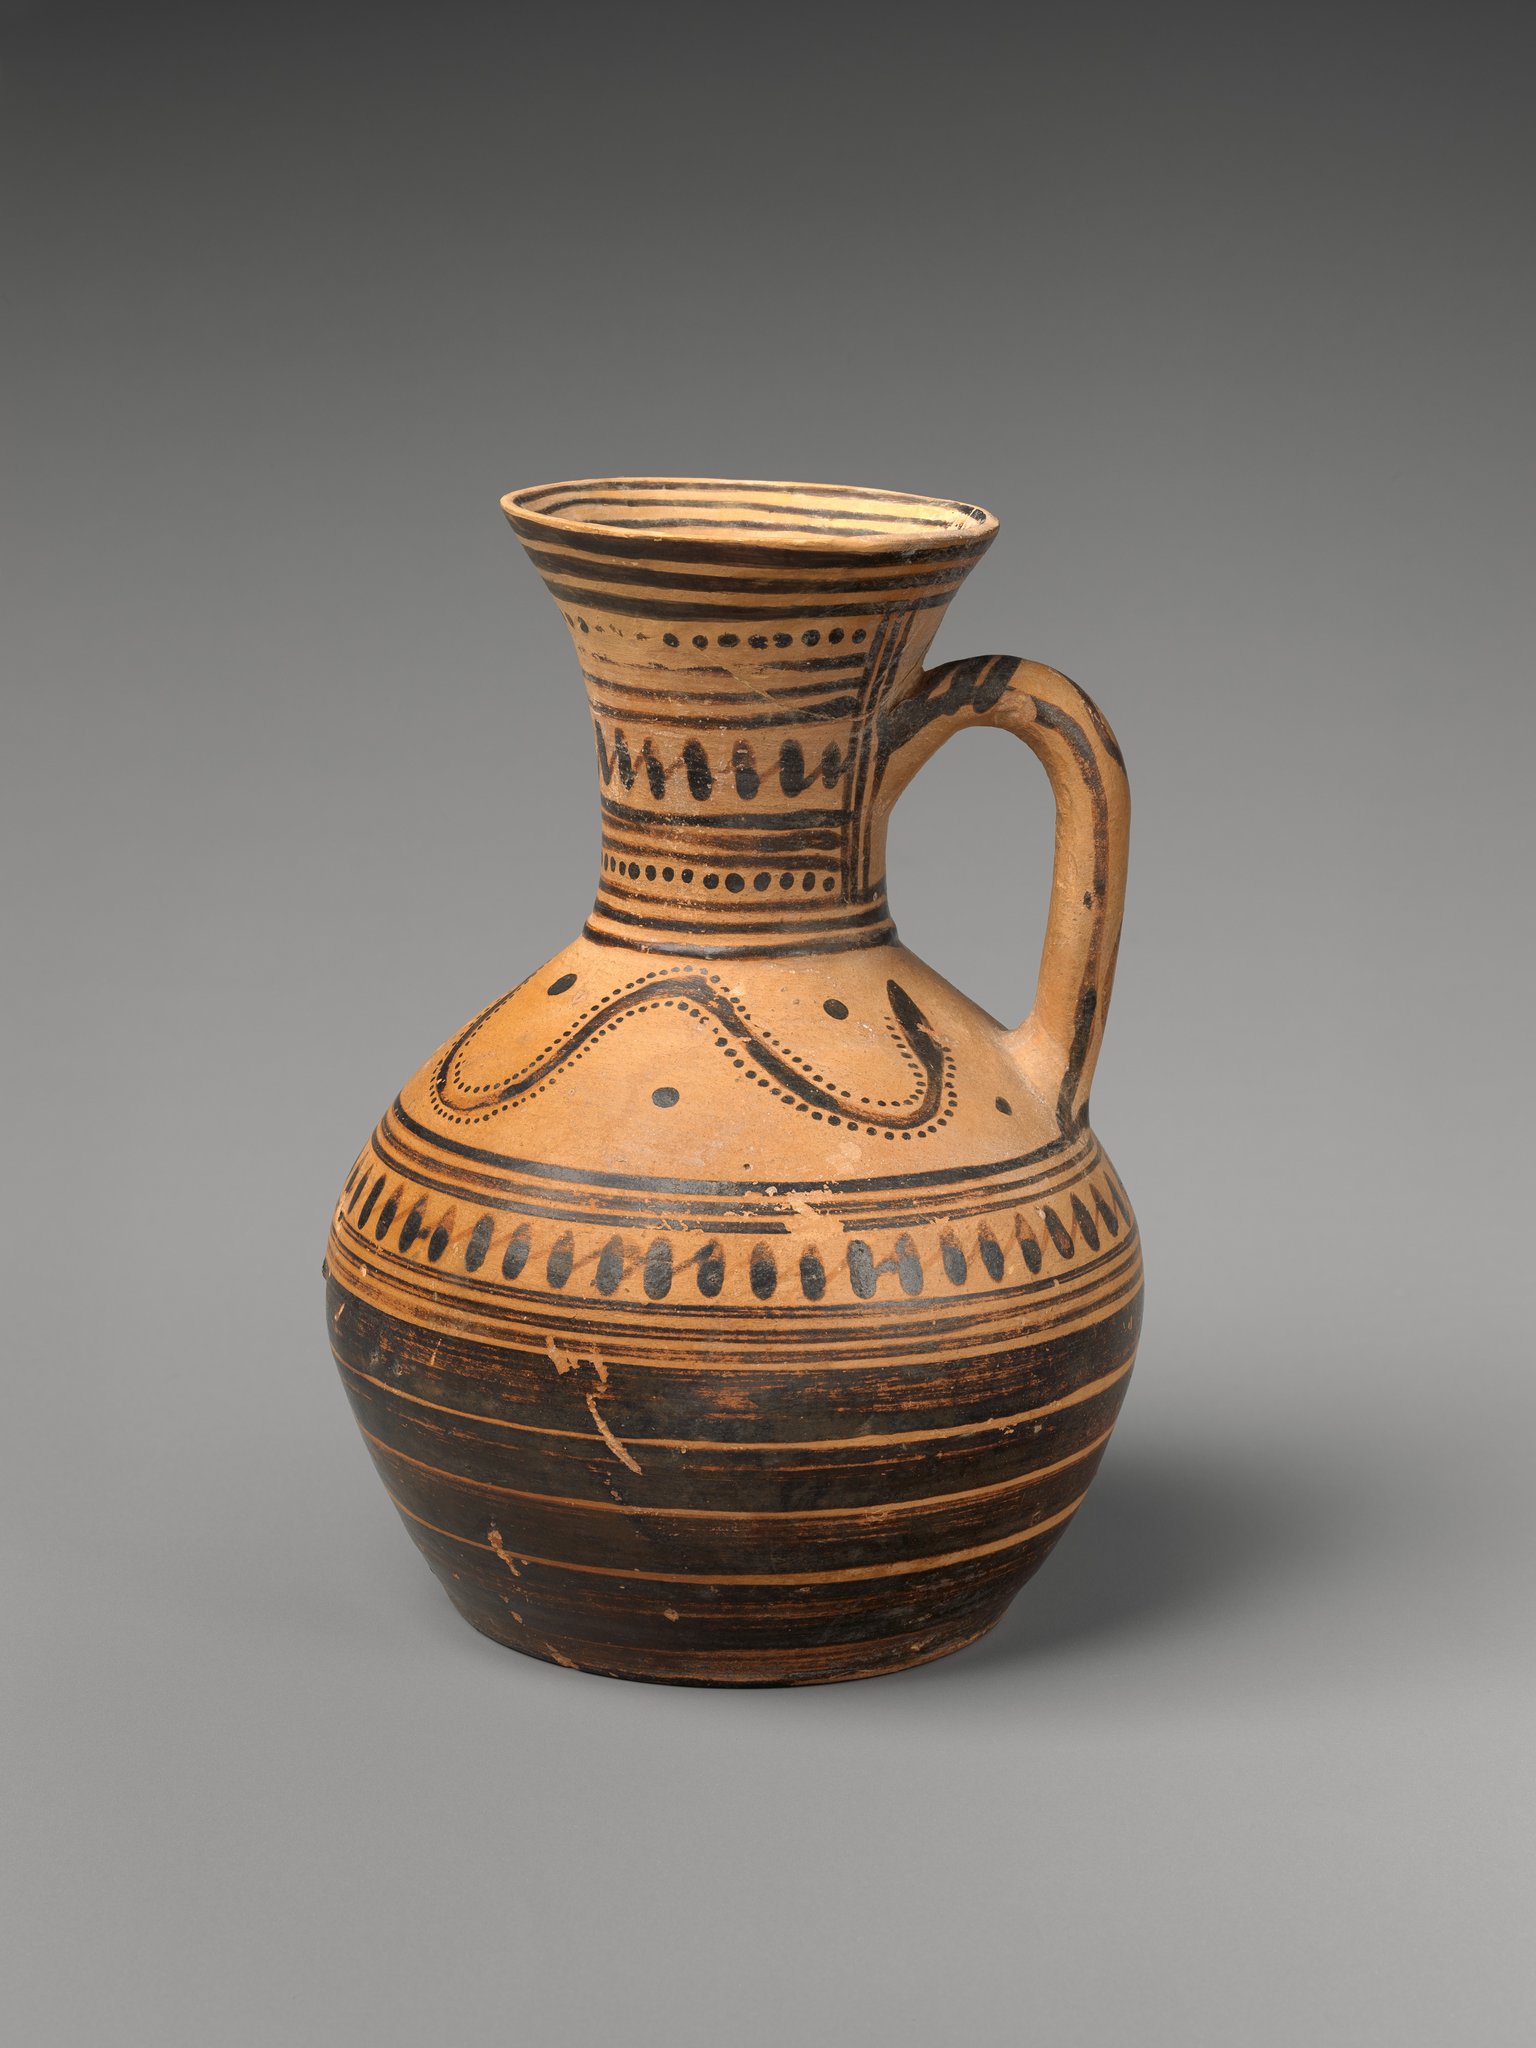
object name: oinochoe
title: Terracotta oinochoe (jug)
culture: greek, attic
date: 800-750 BCE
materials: terracotta